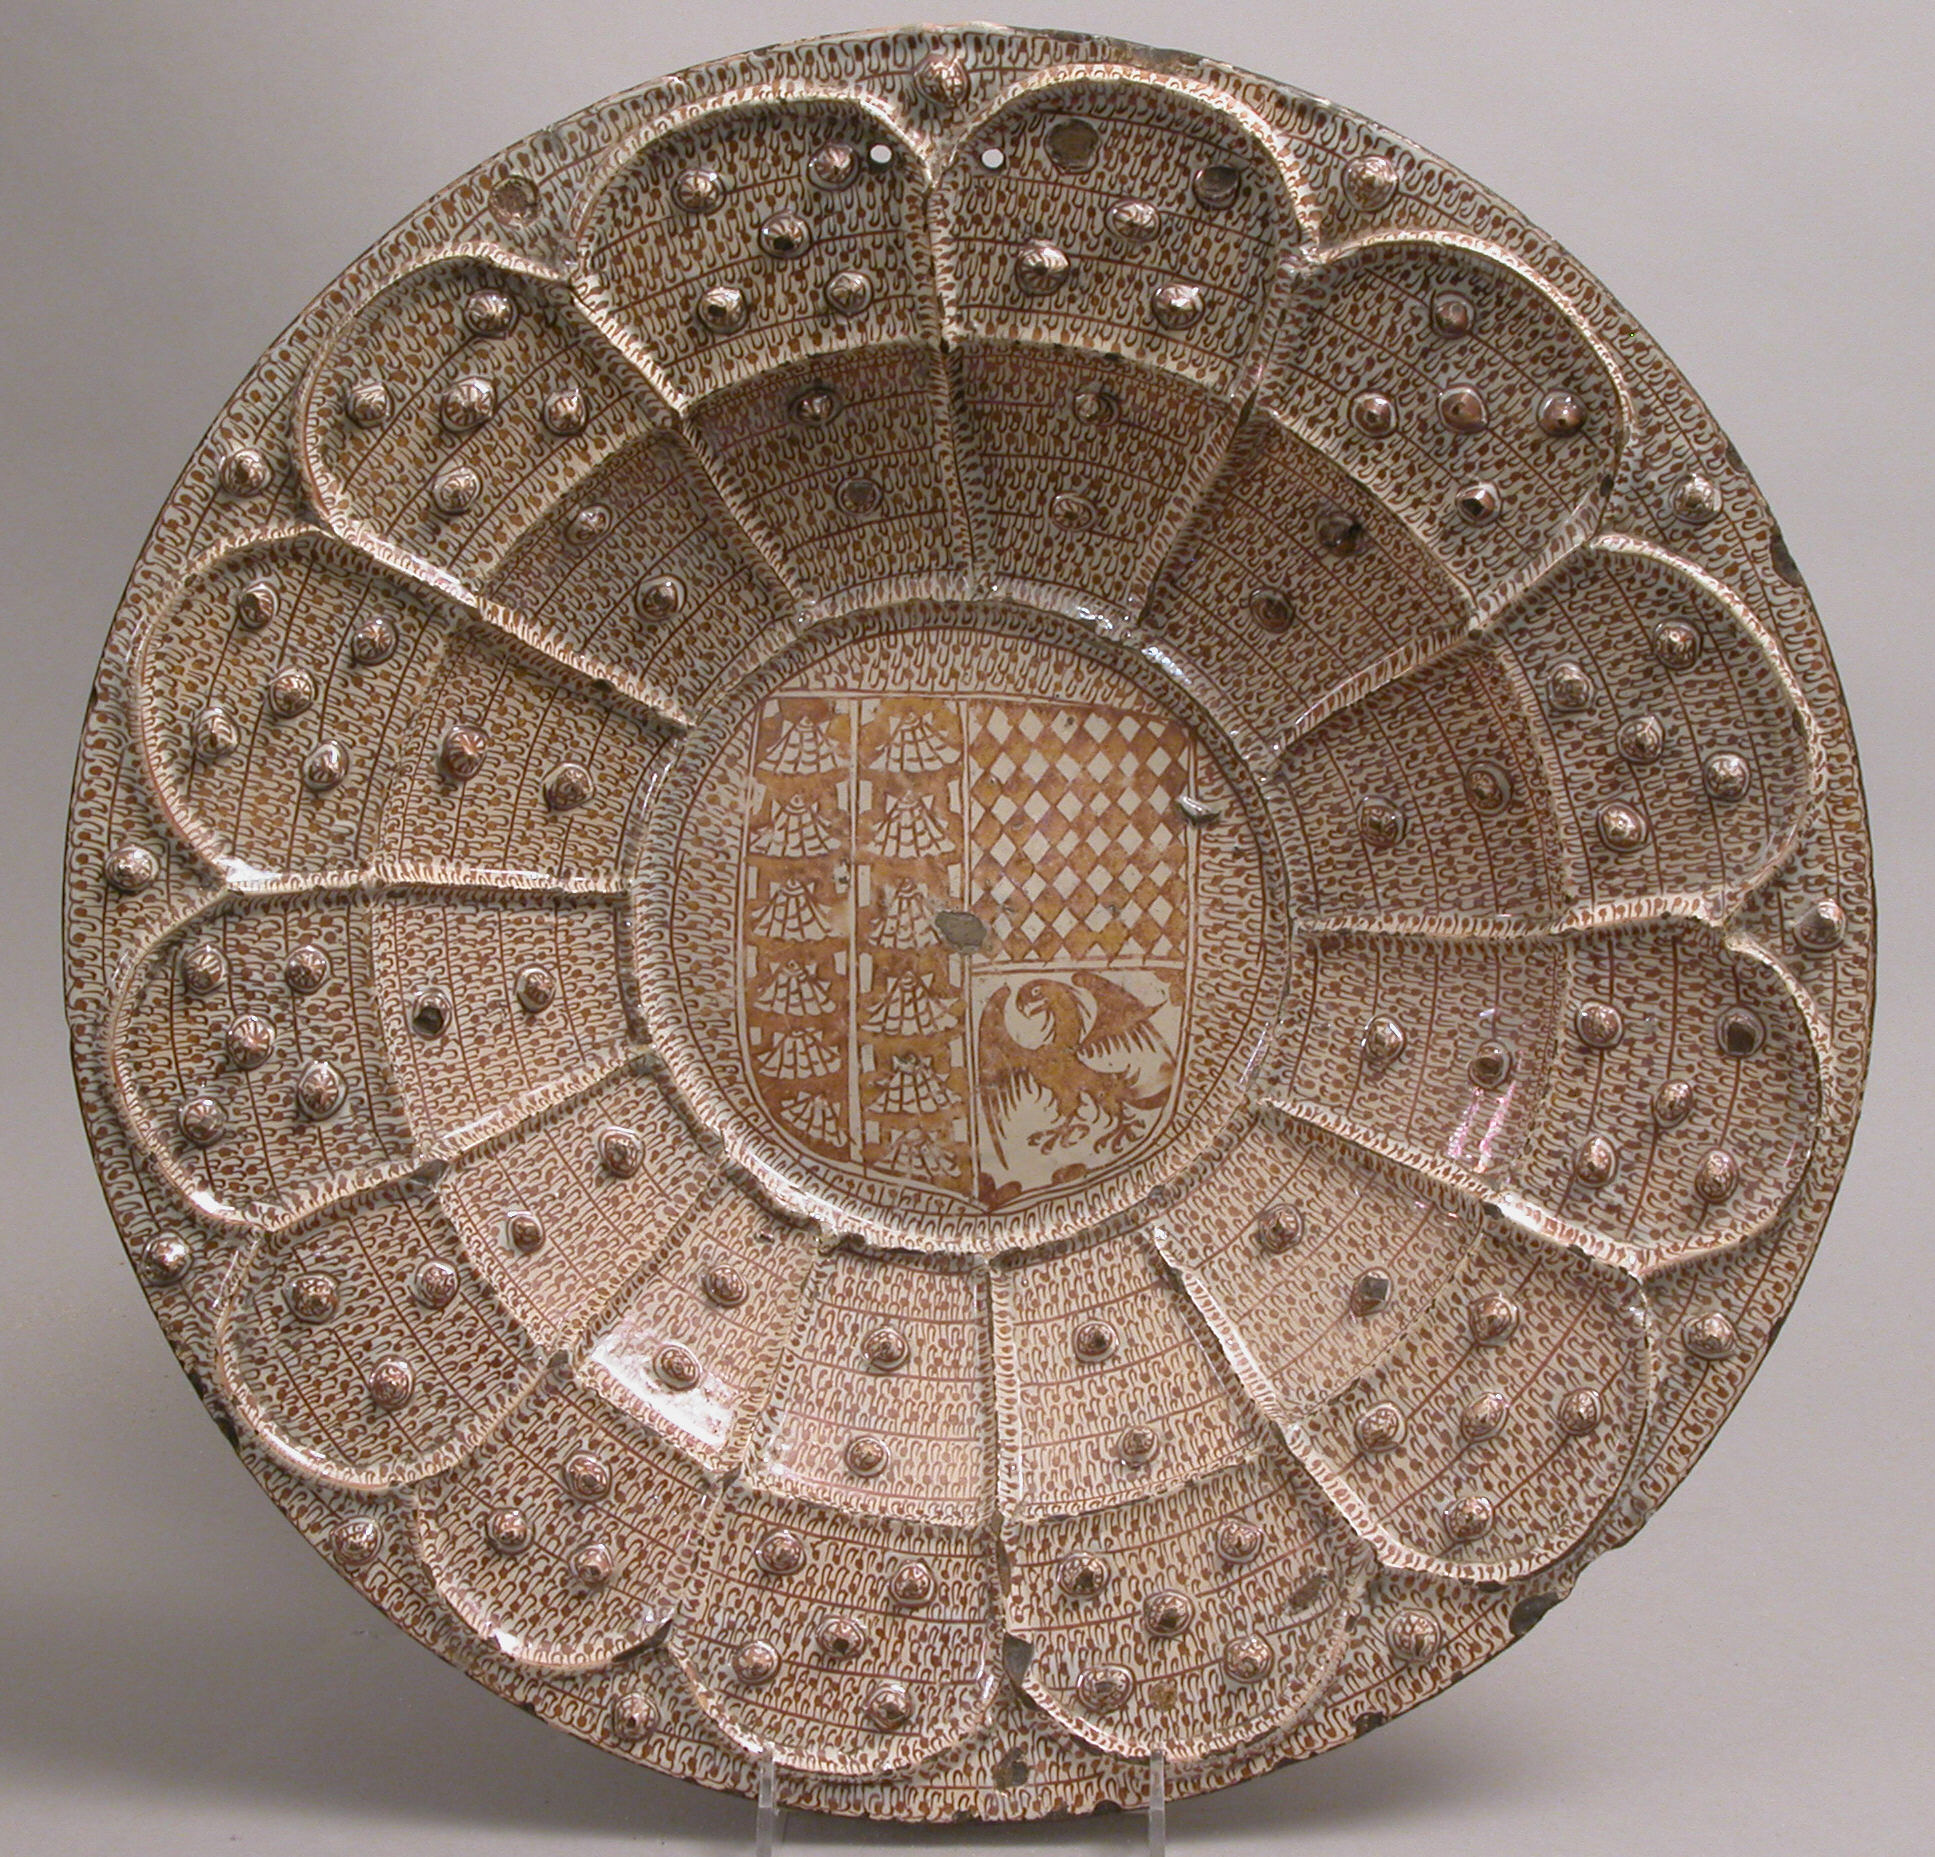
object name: plate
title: Dish with Heraldic Shield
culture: spanish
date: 1470-1500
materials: earthenware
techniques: glazing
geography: spain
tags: coat of arms